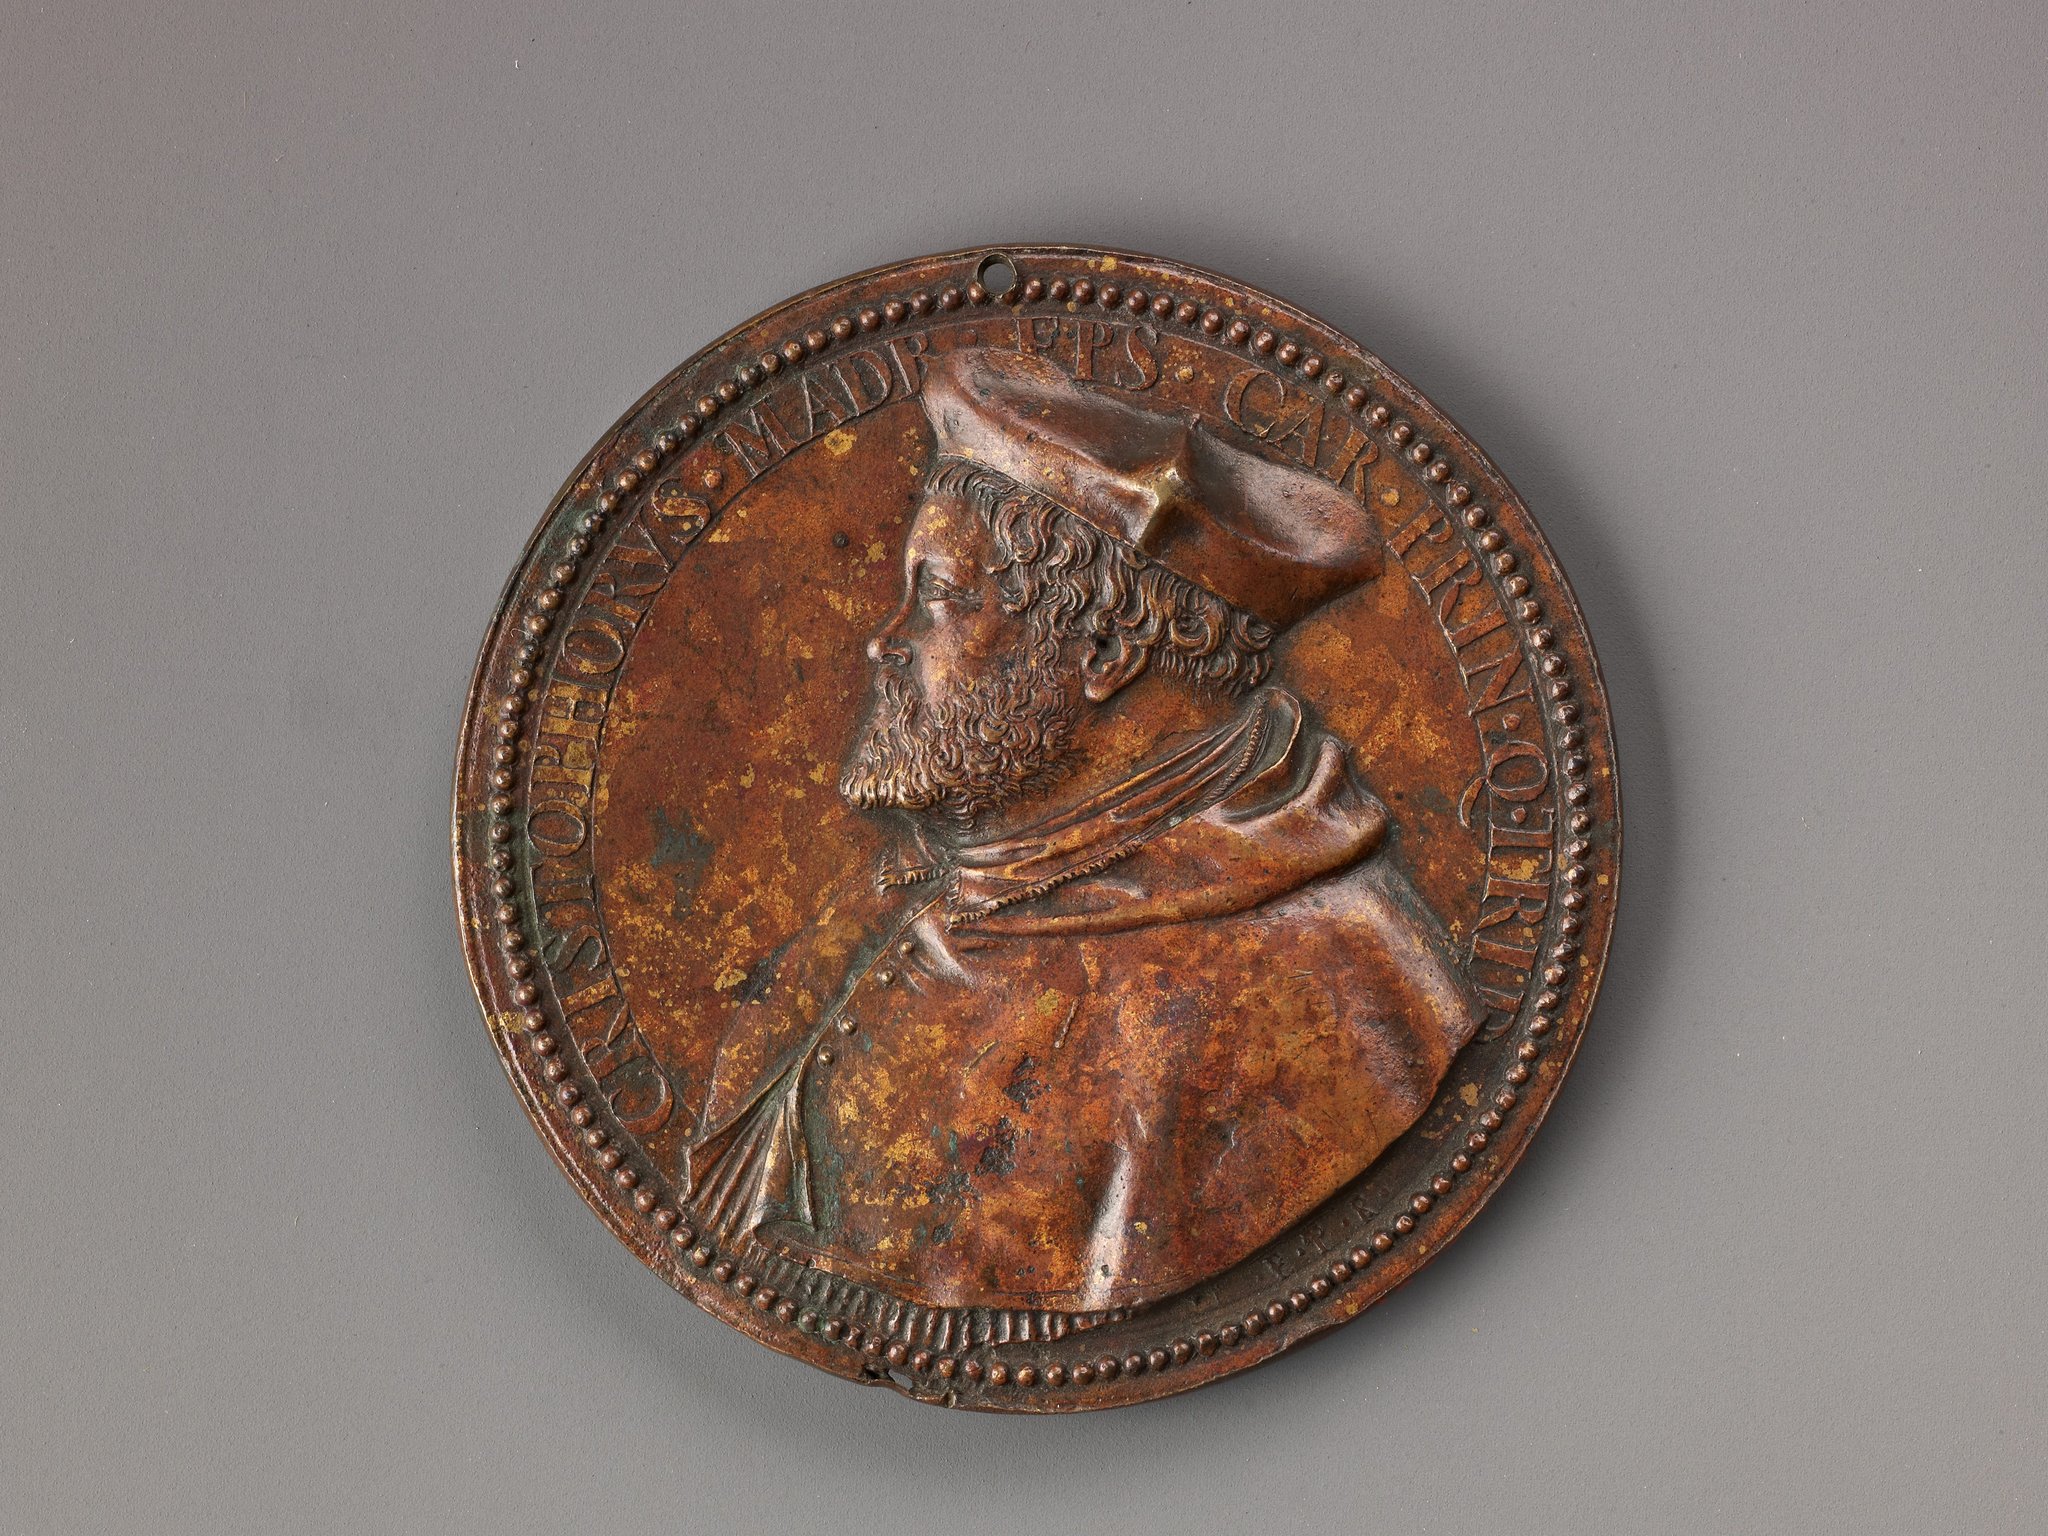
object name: medal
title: Portrait medal of Cristoforo Madruzzo (obverse); Landscape with a Female Figure Pointing to the Sun (reverse)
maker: pietro paolo galeotti ("il romano")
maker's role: artist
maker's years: 1520-1584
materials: bronze, copper alloy, patina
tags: men,portraits,profiles,women,sun